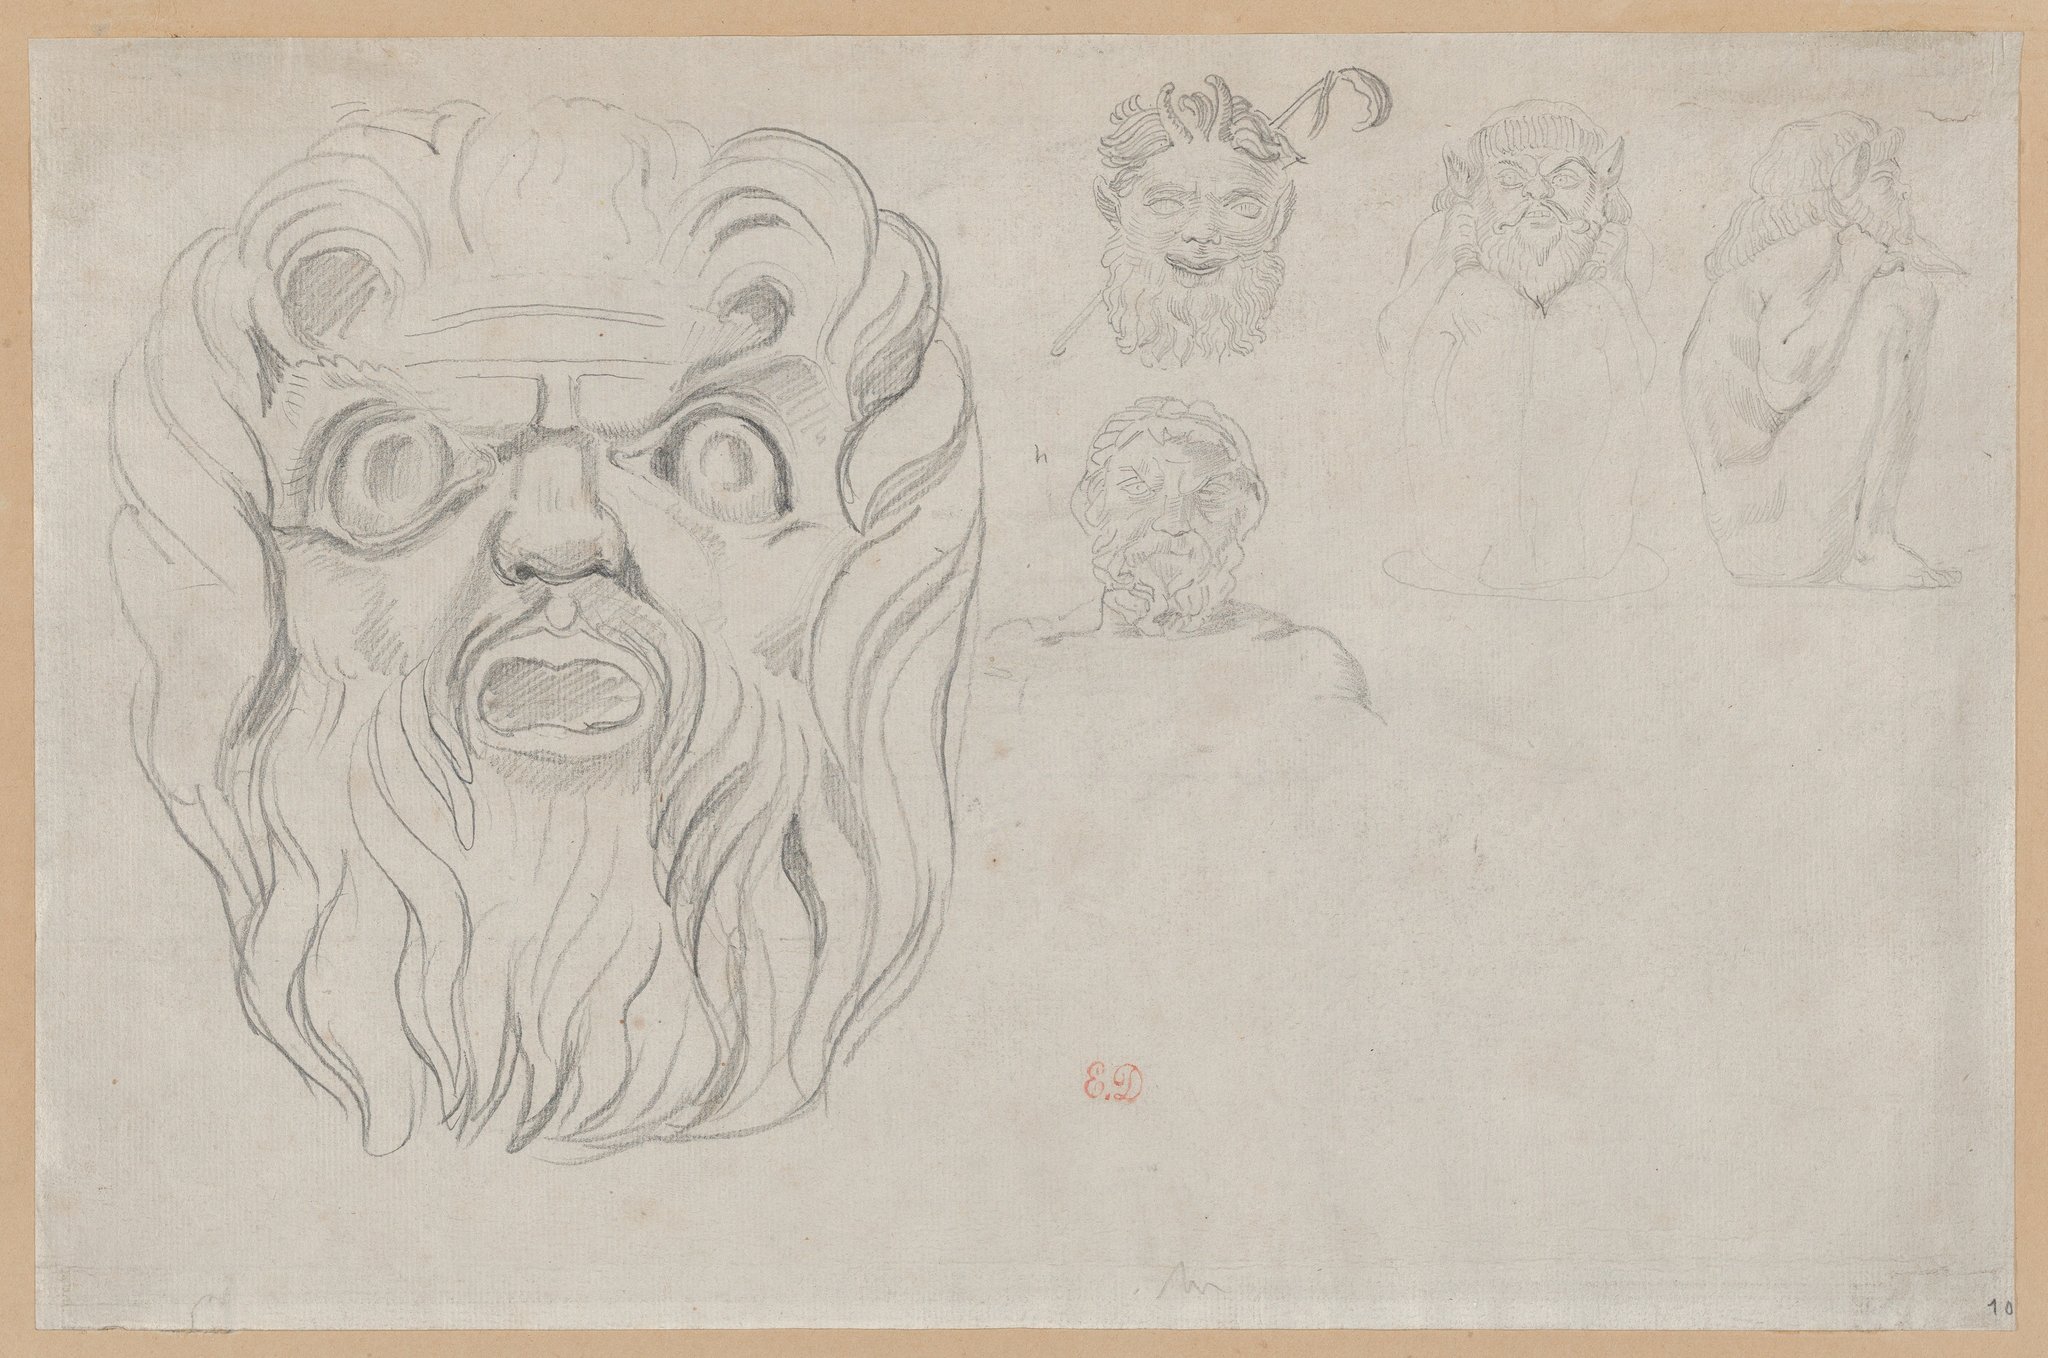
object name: drawing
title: Studies of Greco-Roman Sculpture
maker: eugène delacroix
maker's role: artist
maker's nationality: french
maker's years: 1798-1863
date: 1833-1838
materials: graphite